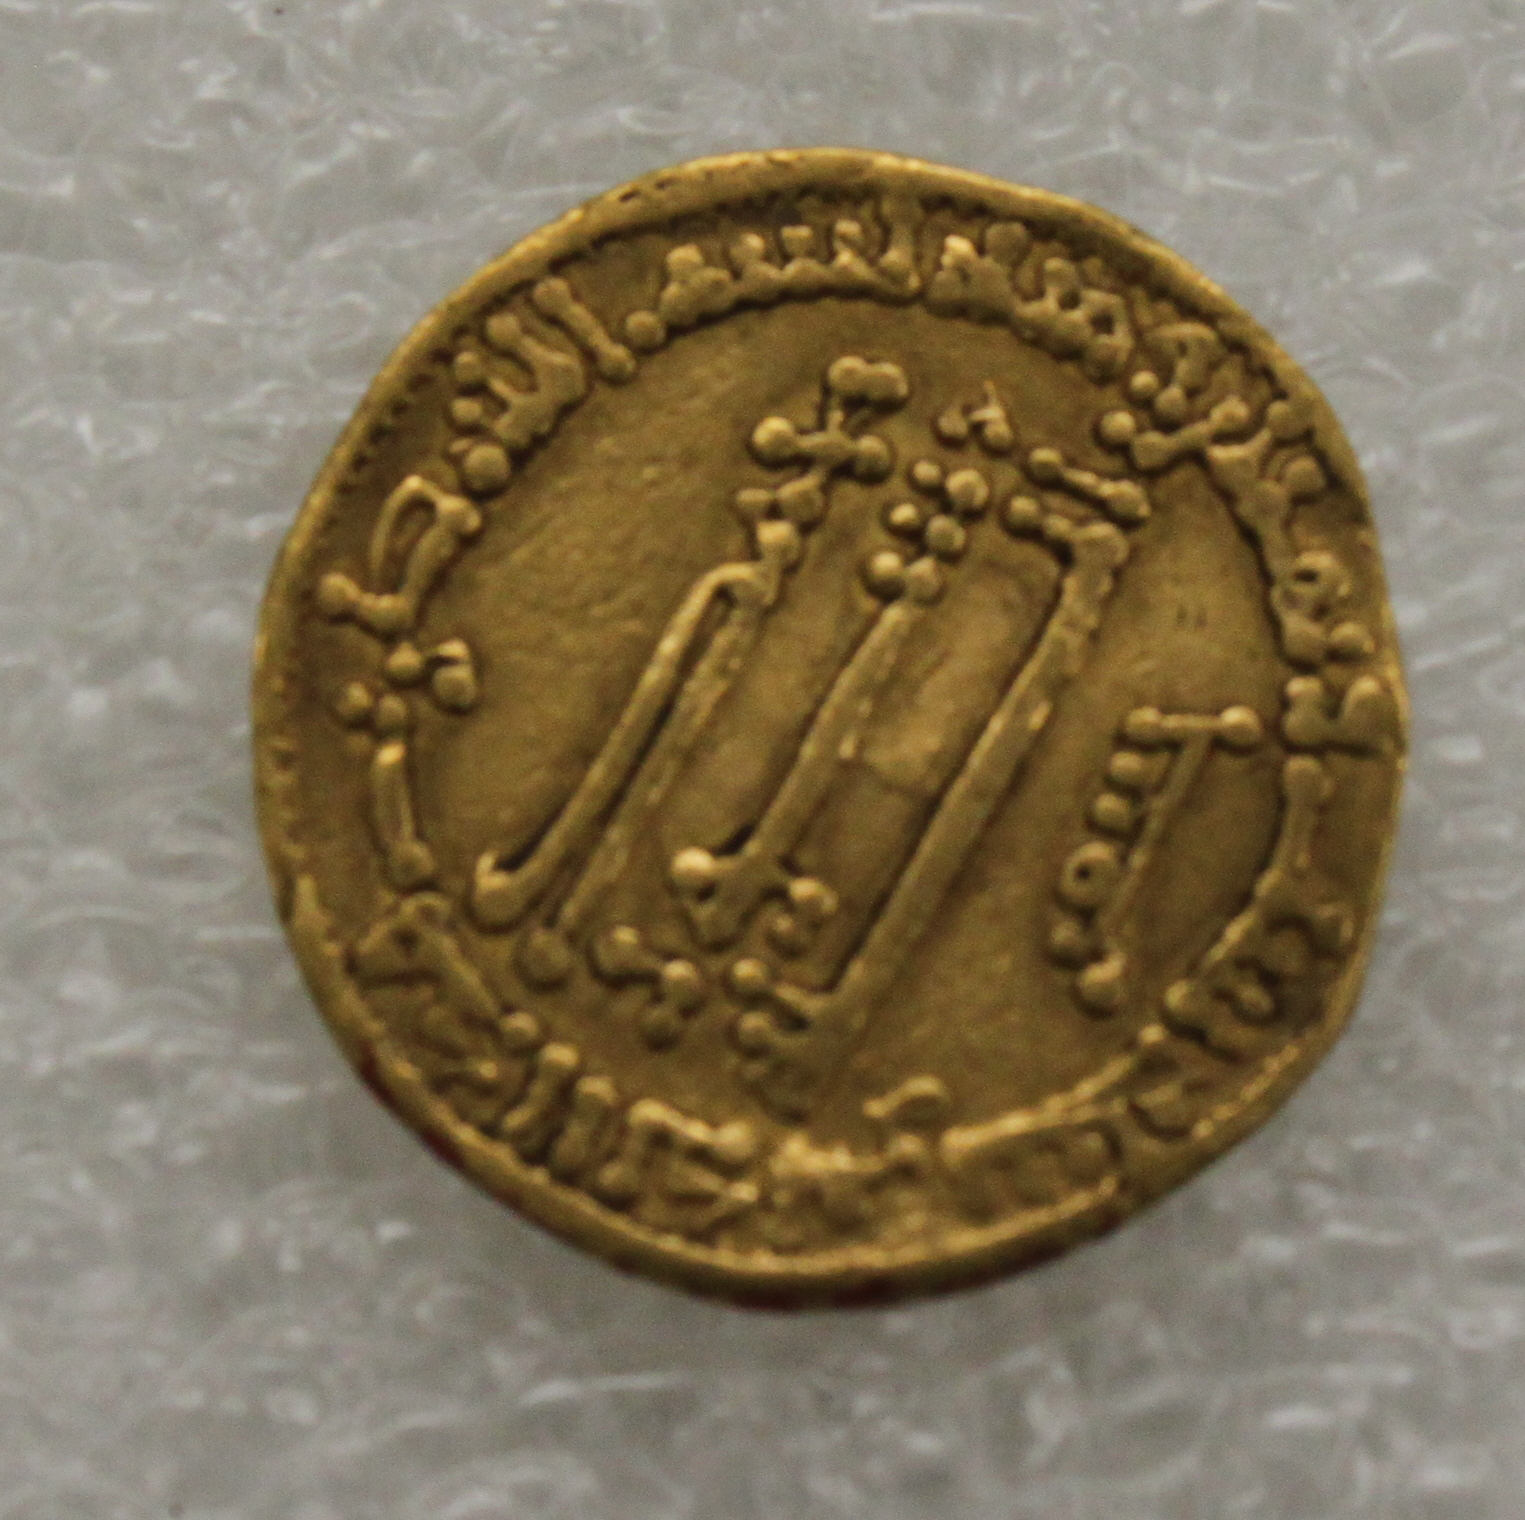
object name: coin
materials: gold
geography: iraq